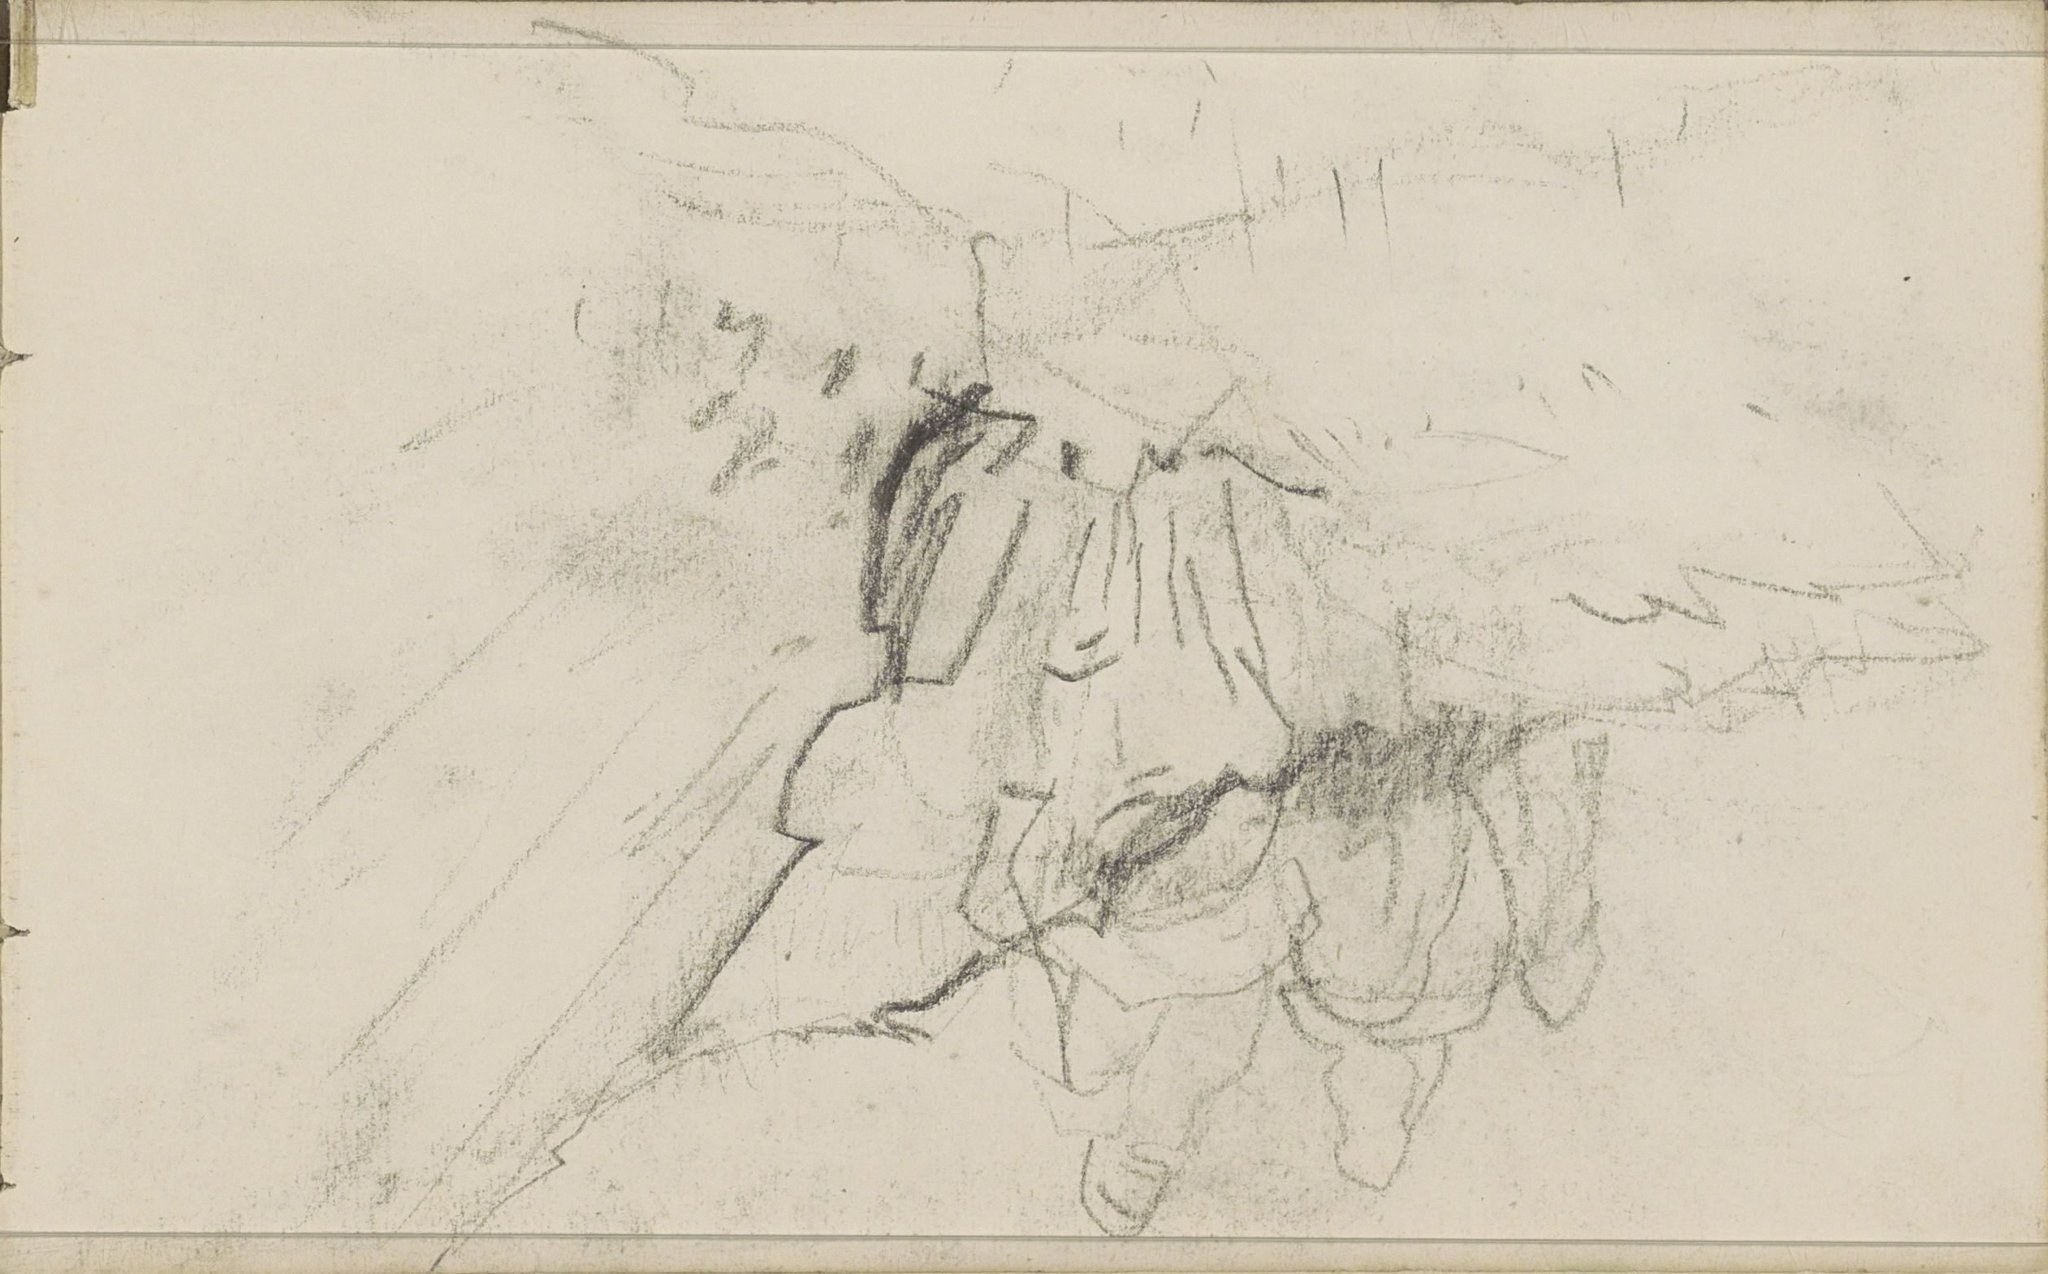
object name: sketchbook leaf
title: Studie, vermoedelijk ruiters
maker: anton mauve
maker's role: draughtsman, painter, print maker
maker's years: 1838-1888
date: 1848-1888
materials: chalk, paper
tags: riding a horse, ass, or mule; rider, horseman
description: Blad 21 recto uit een schetsboek met 42 bladen.